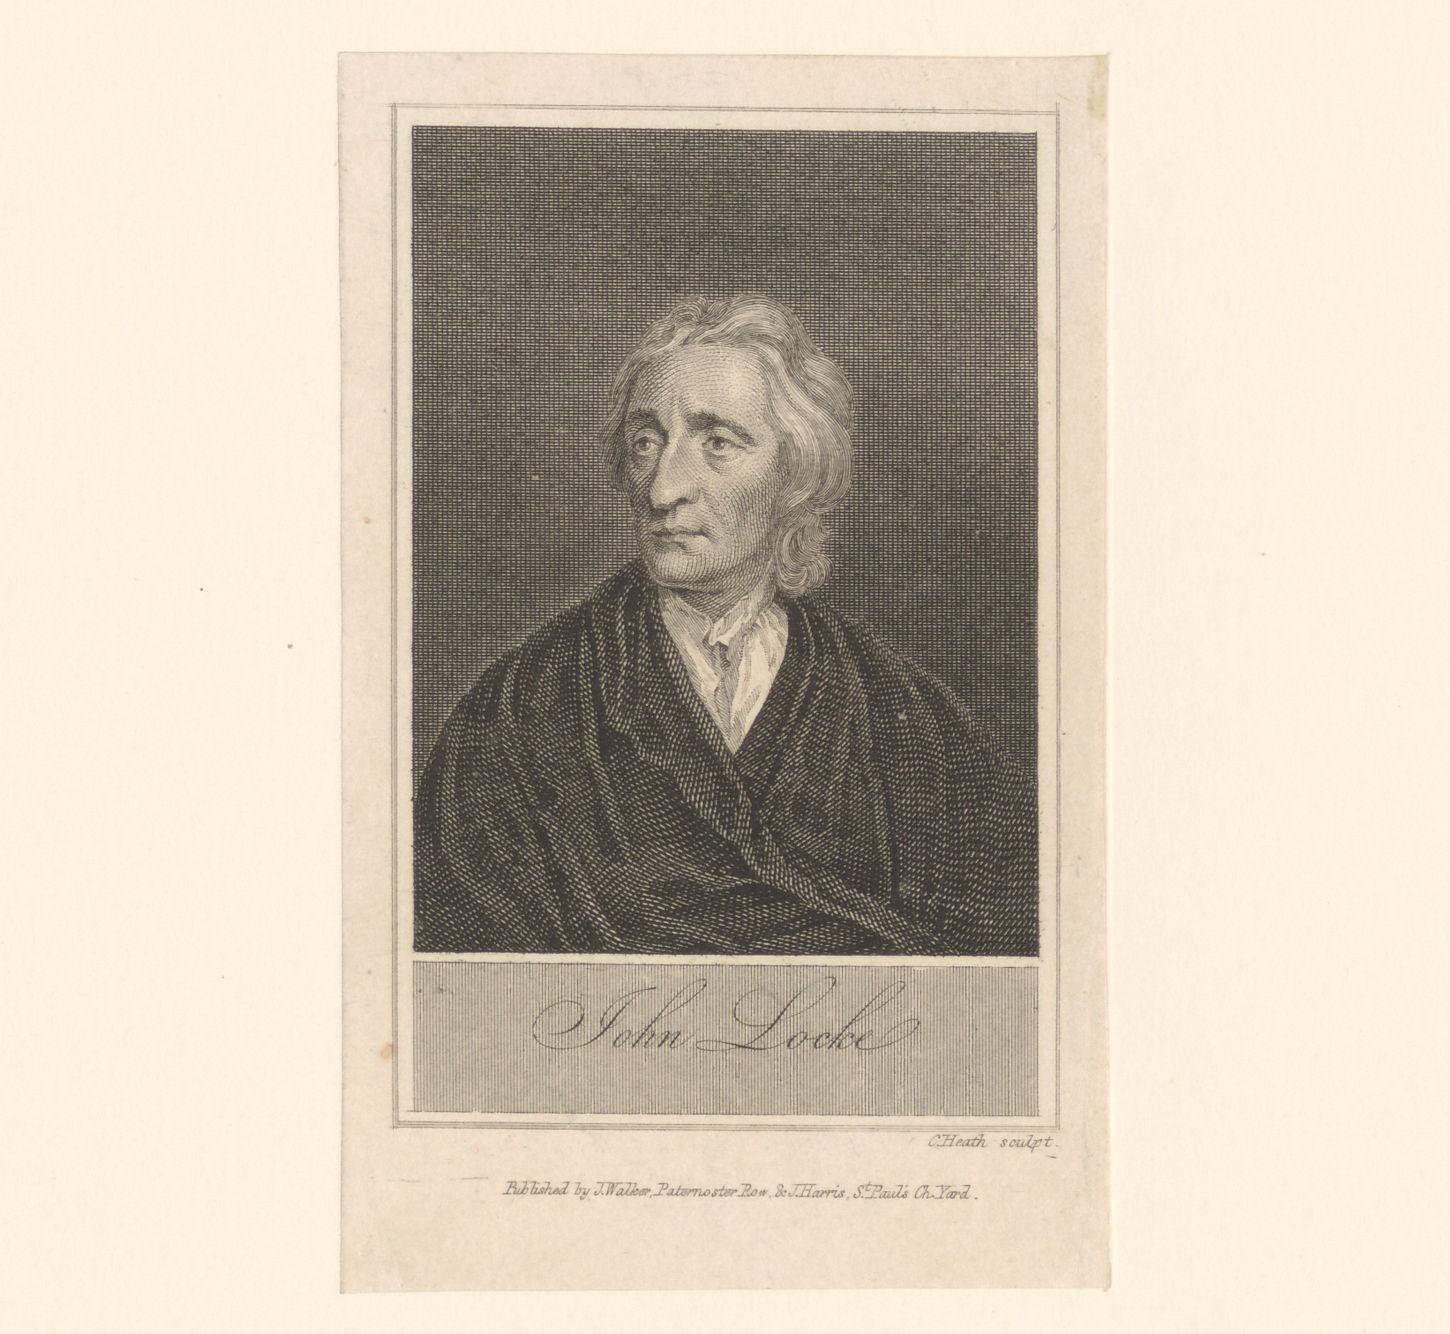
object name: print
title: John Locke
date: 1795-1846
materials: paper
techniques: etching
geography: london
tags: politician, physicist, historical persons, scholar, philosopher (+ portrait of scholar, scientist)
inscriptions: collector's mark: Lugt 2228